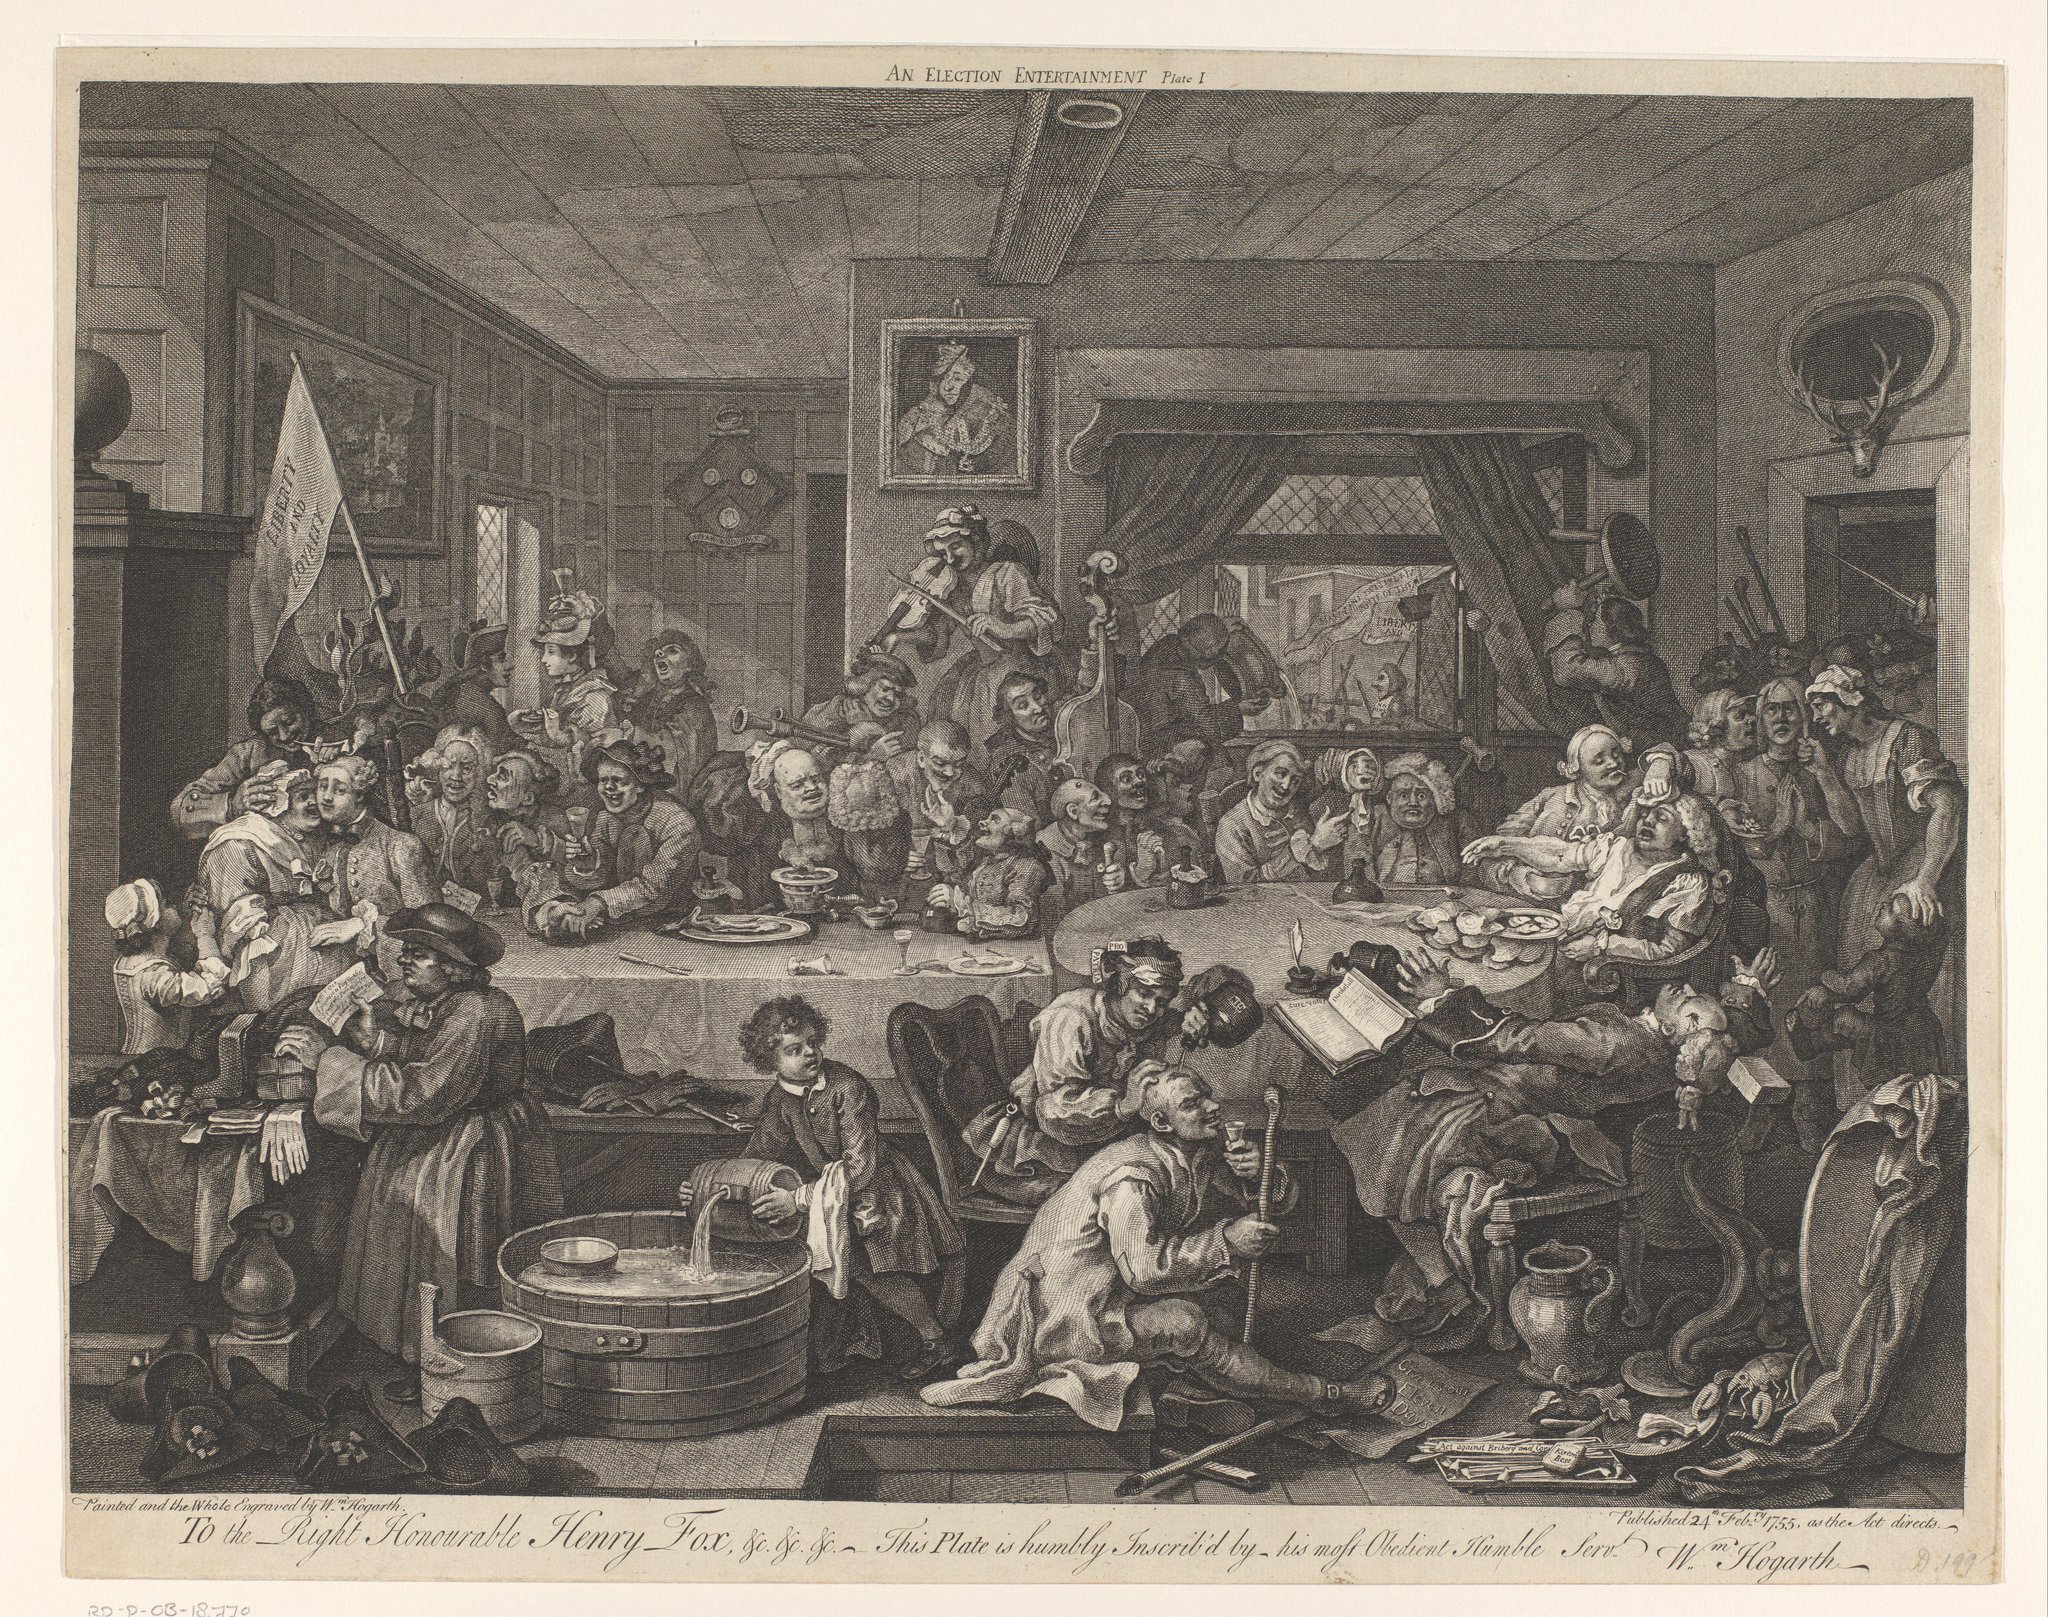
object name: print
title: Vier prenten over een verkiezing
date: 1755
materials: paper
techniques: engraving, etching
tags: voting propaganda, political caricatures and satires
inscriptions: collector's mark: Lugt 240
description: Tekst in het Engels in de ondermarge. In een herberg proberen twee verkiezingskandidaten burgers te overtuigen met behulp van ondeugdelijke middelen. Buiten demonstreren mensen van het oude beleid.